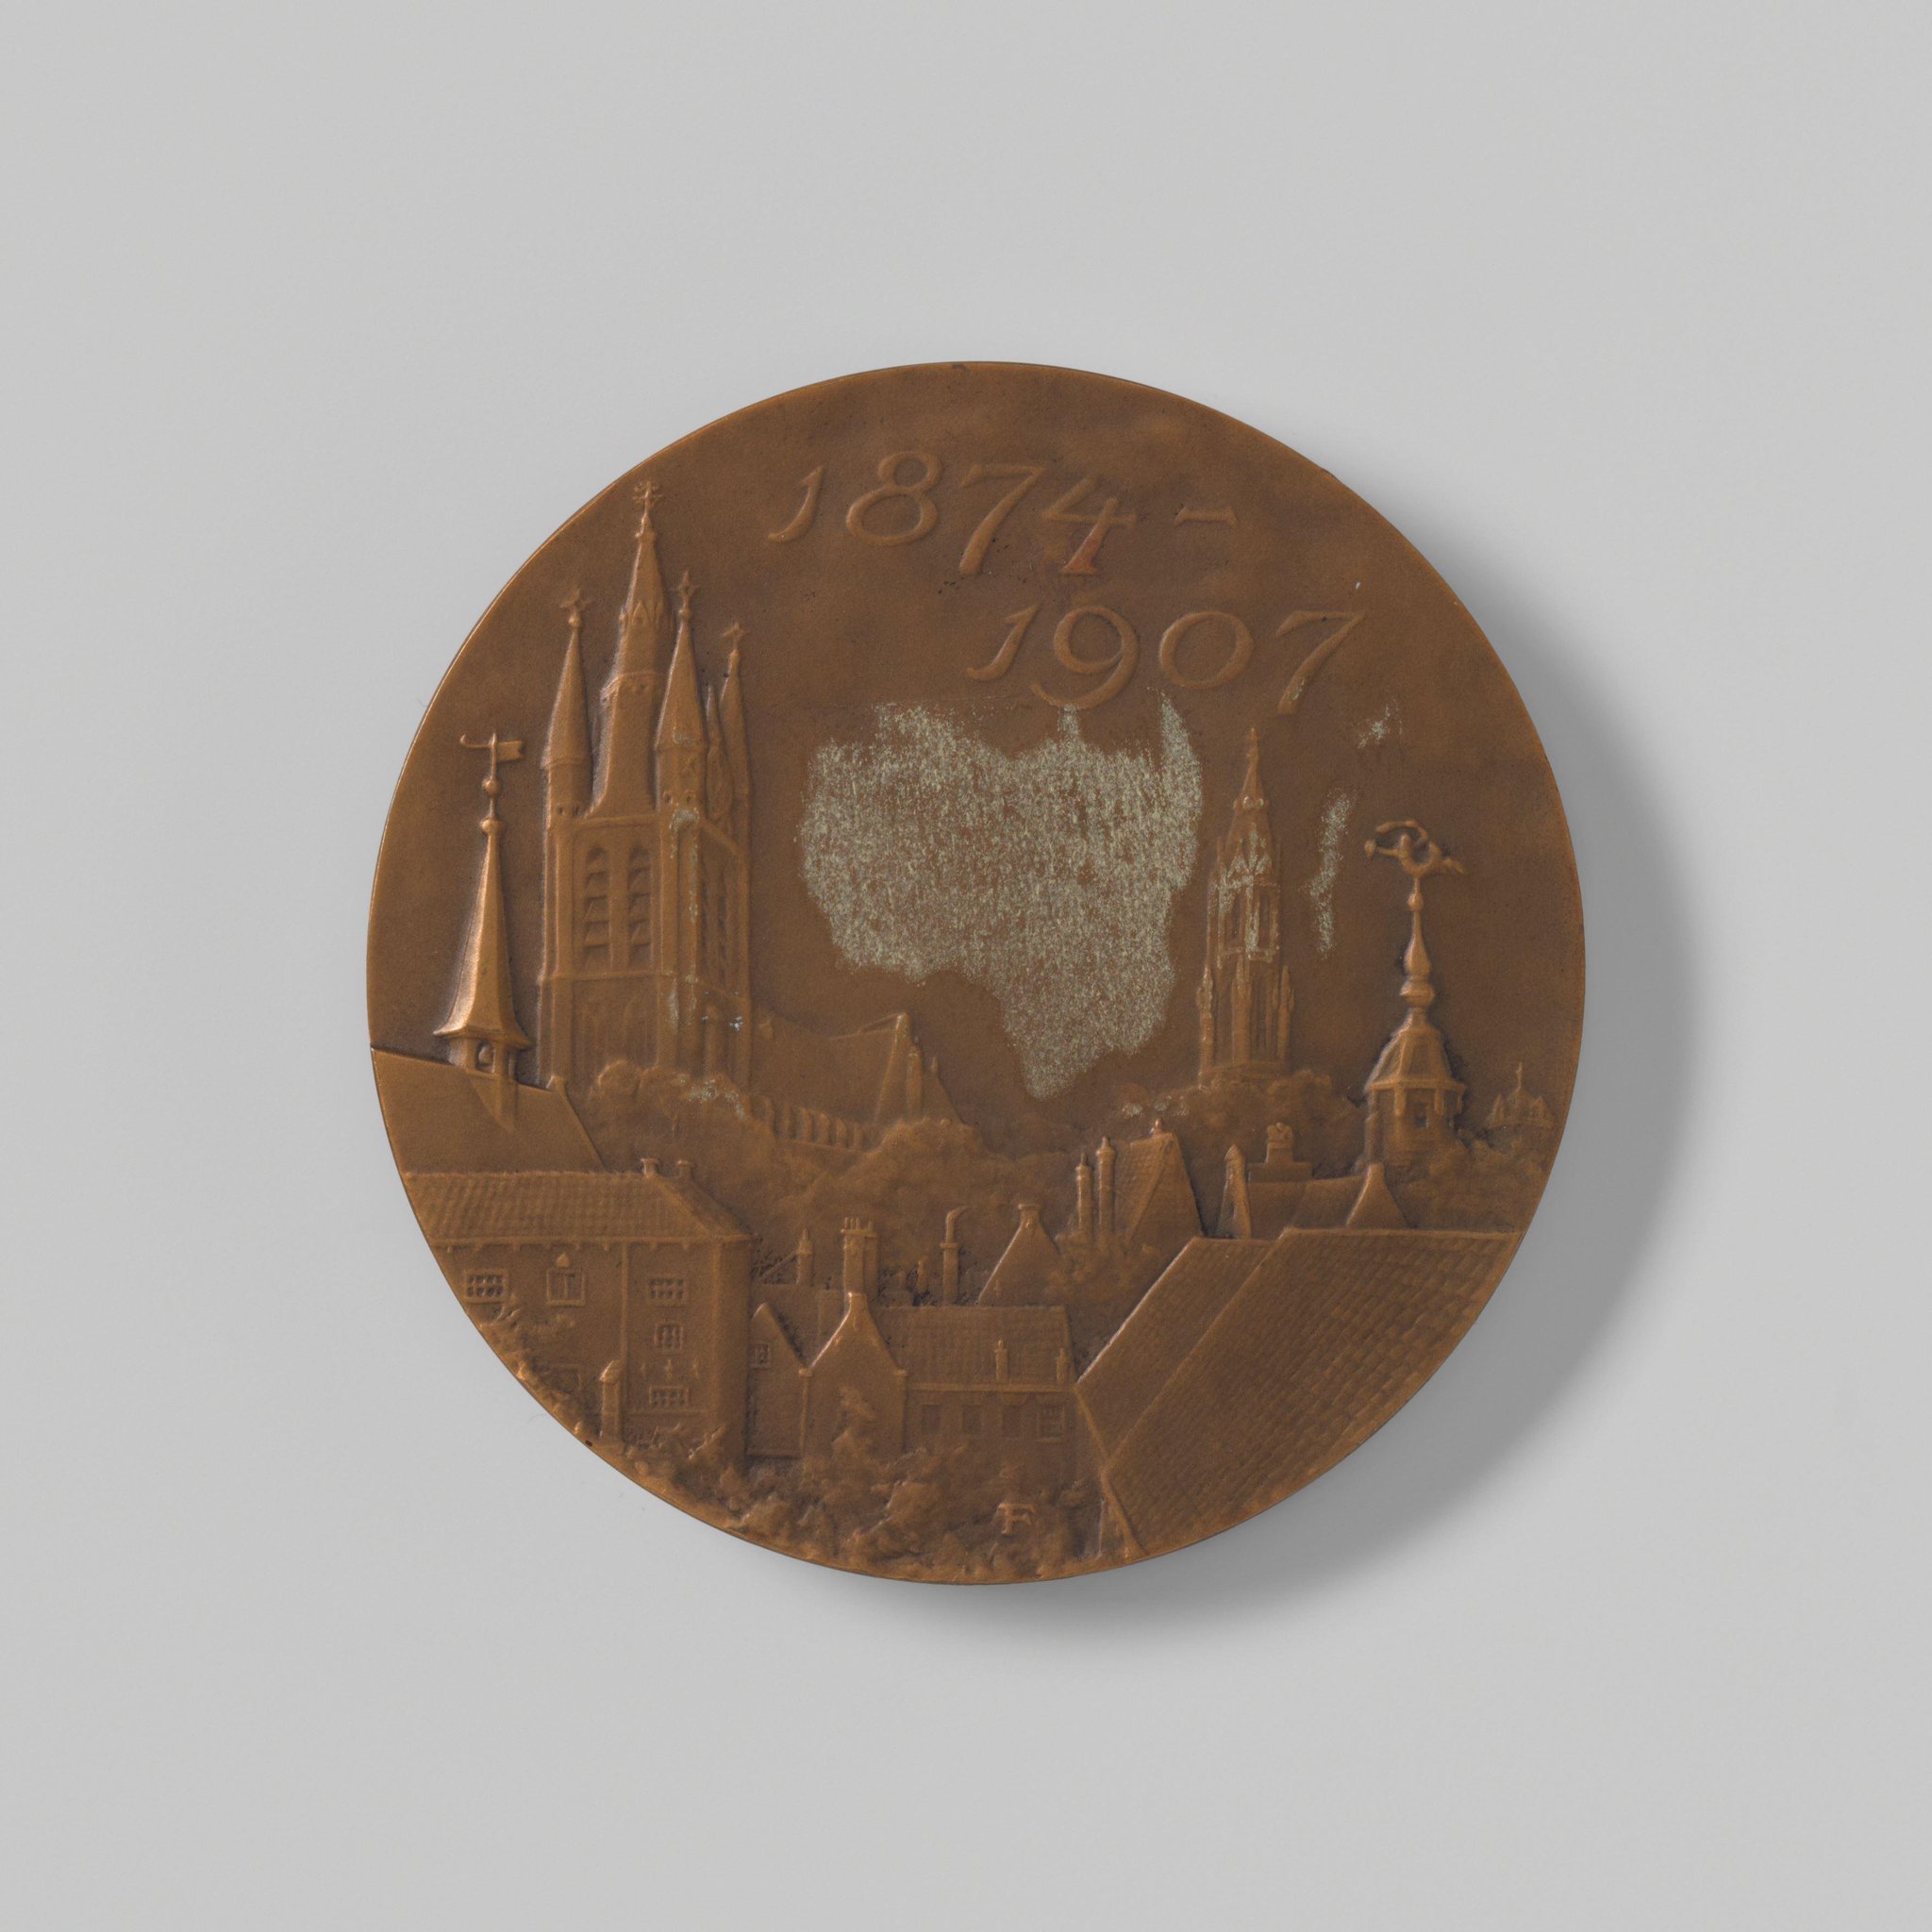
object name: medal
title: Baltus Hendrik Pekelharing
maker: johan melchior faddegon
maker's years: 1871-1941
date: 1907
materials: bronze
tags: the hague, university, delft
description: Penning van brons met portret van Baltus Hendrik Pekelharing, hoogleraar. Op de achterzijde een stadsgezicht (Delft?) en de data 1874-1907.